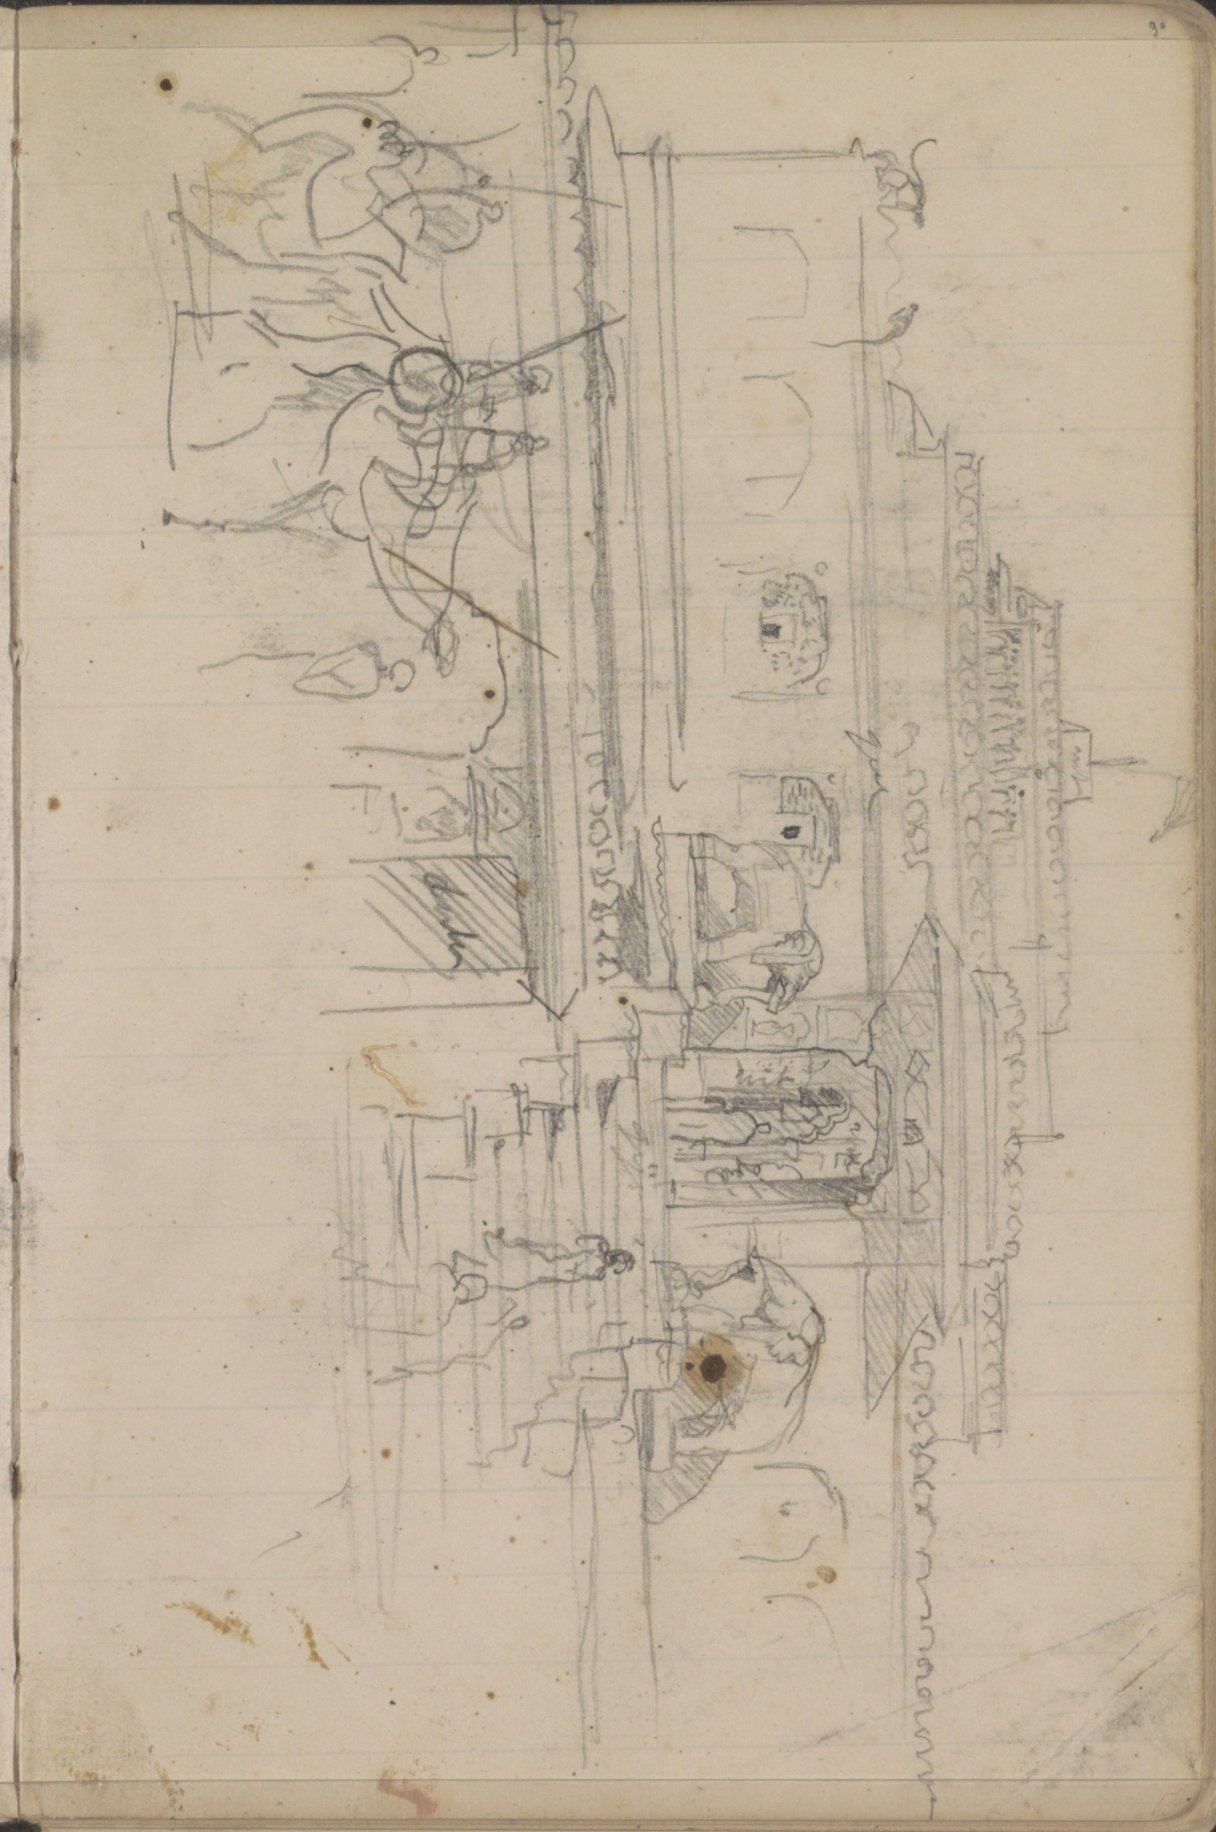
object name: sketchbook leaf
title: Trappen van een gebouw, mogelijk een tempel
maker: marius bauer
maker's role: draughtsman, print maker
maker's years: 1867-1932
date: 1897-1898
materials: pencil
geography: jaipur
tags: riding a horse, ass, or mule; rider, horseman, temple, shrine ~ hinduism, buddhism, jainism, flight of steps, sculpture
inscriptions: kleurnotitie, handgeschreven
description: Bij het portaal staan twee beeldhouwwerken van olifanten. Op de voorgrond enkele ruiters. Pagina 90 uit een schetsboek met 84 bladen.